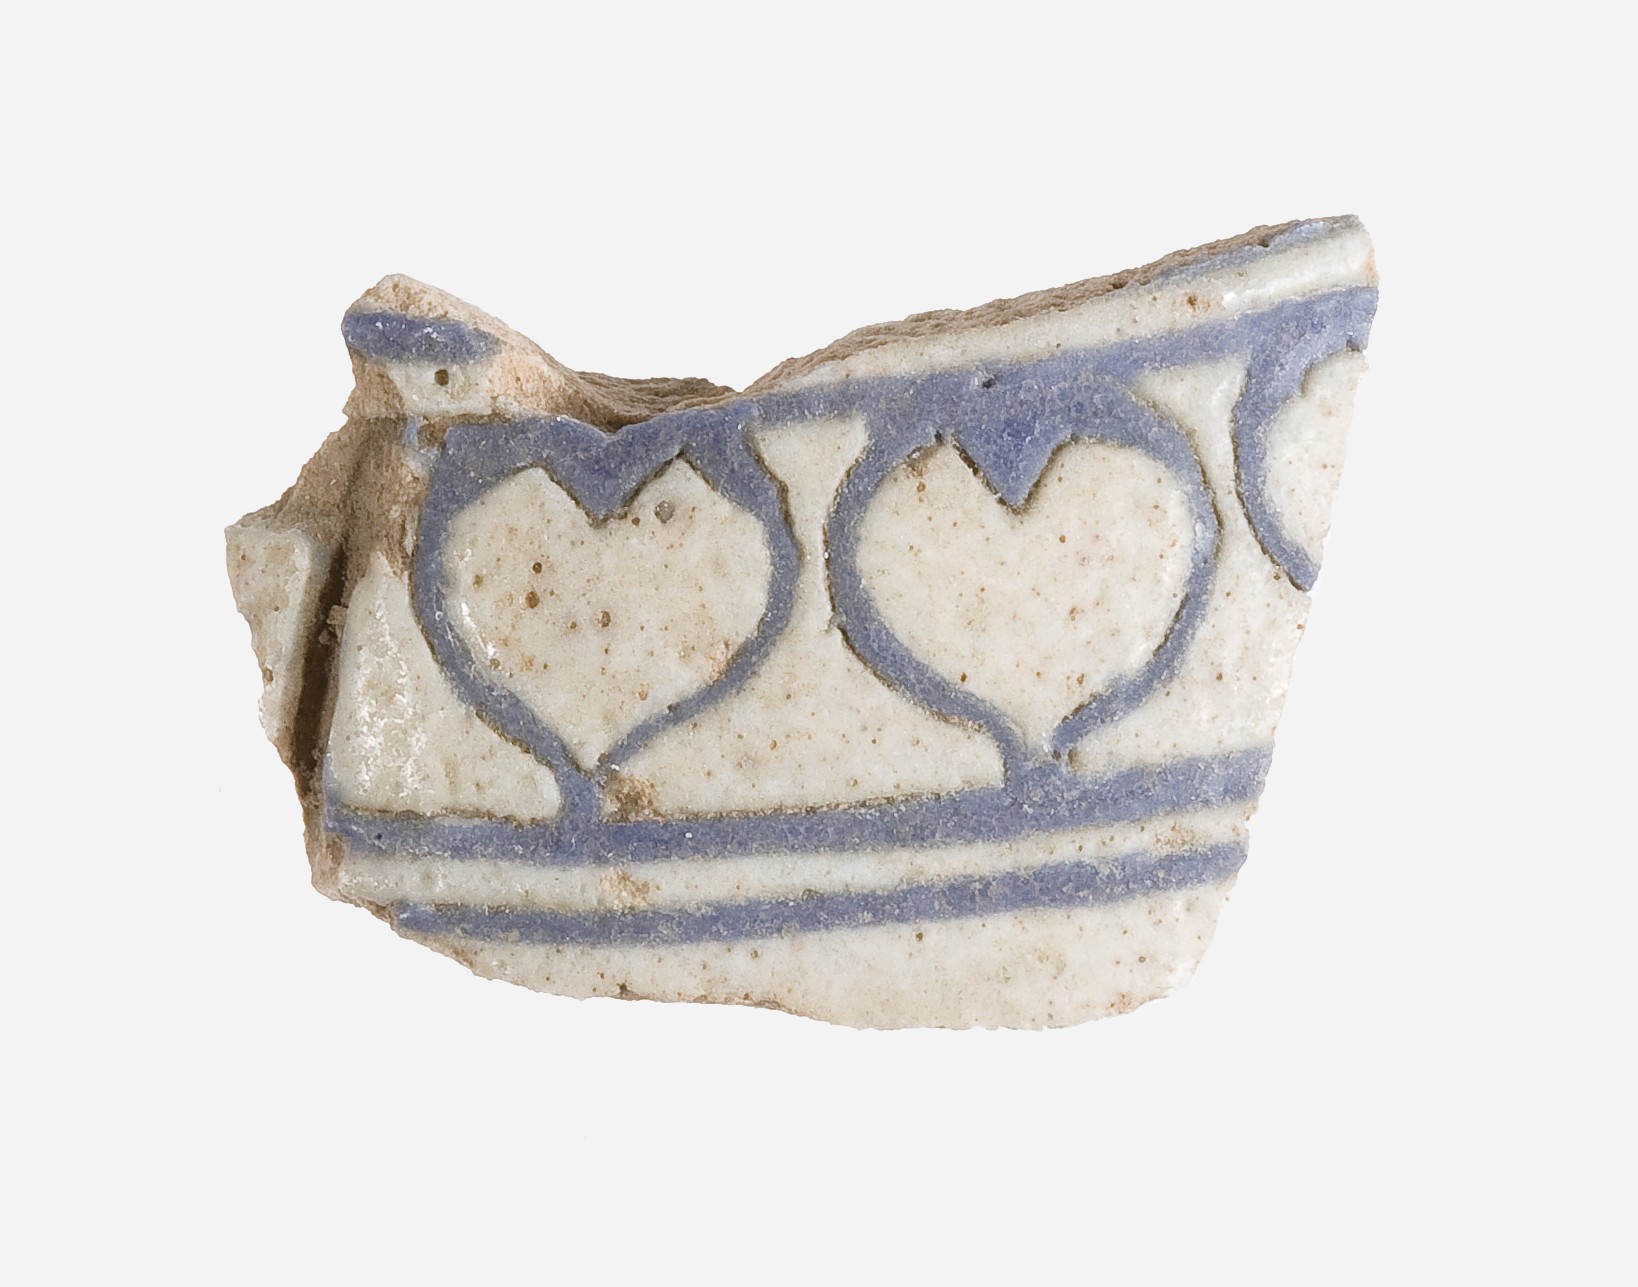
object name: vase fragment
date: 1390-1352 BCE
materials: faience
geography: egypt